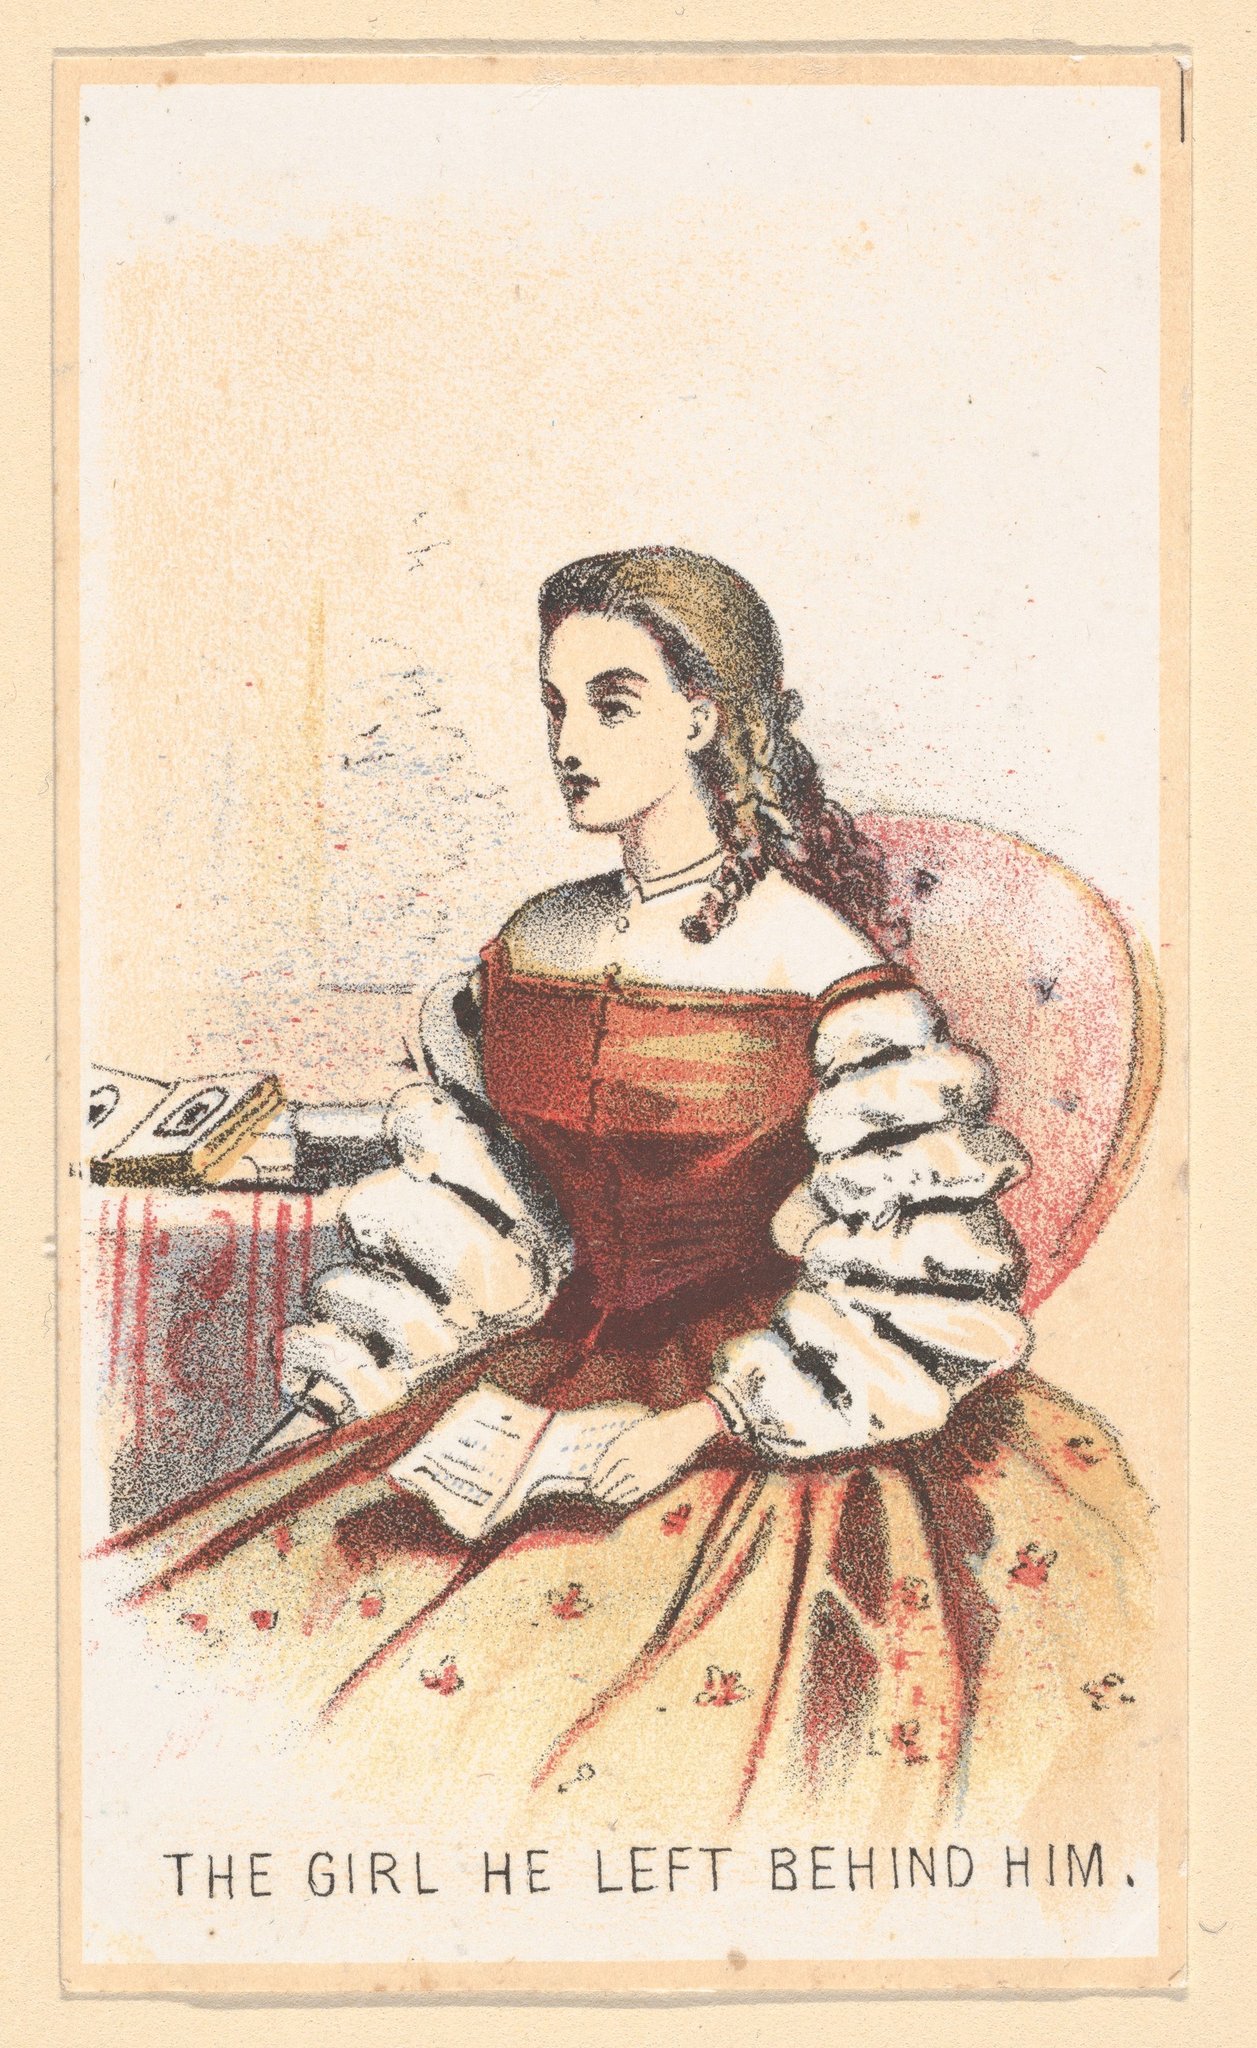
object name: print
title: Life in Camp, Part 2: The Girl He Left Behind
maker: winslow homer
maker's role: artist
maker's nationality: american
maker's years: 1836-1910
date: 1864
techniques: lithograph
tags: american civil war,women